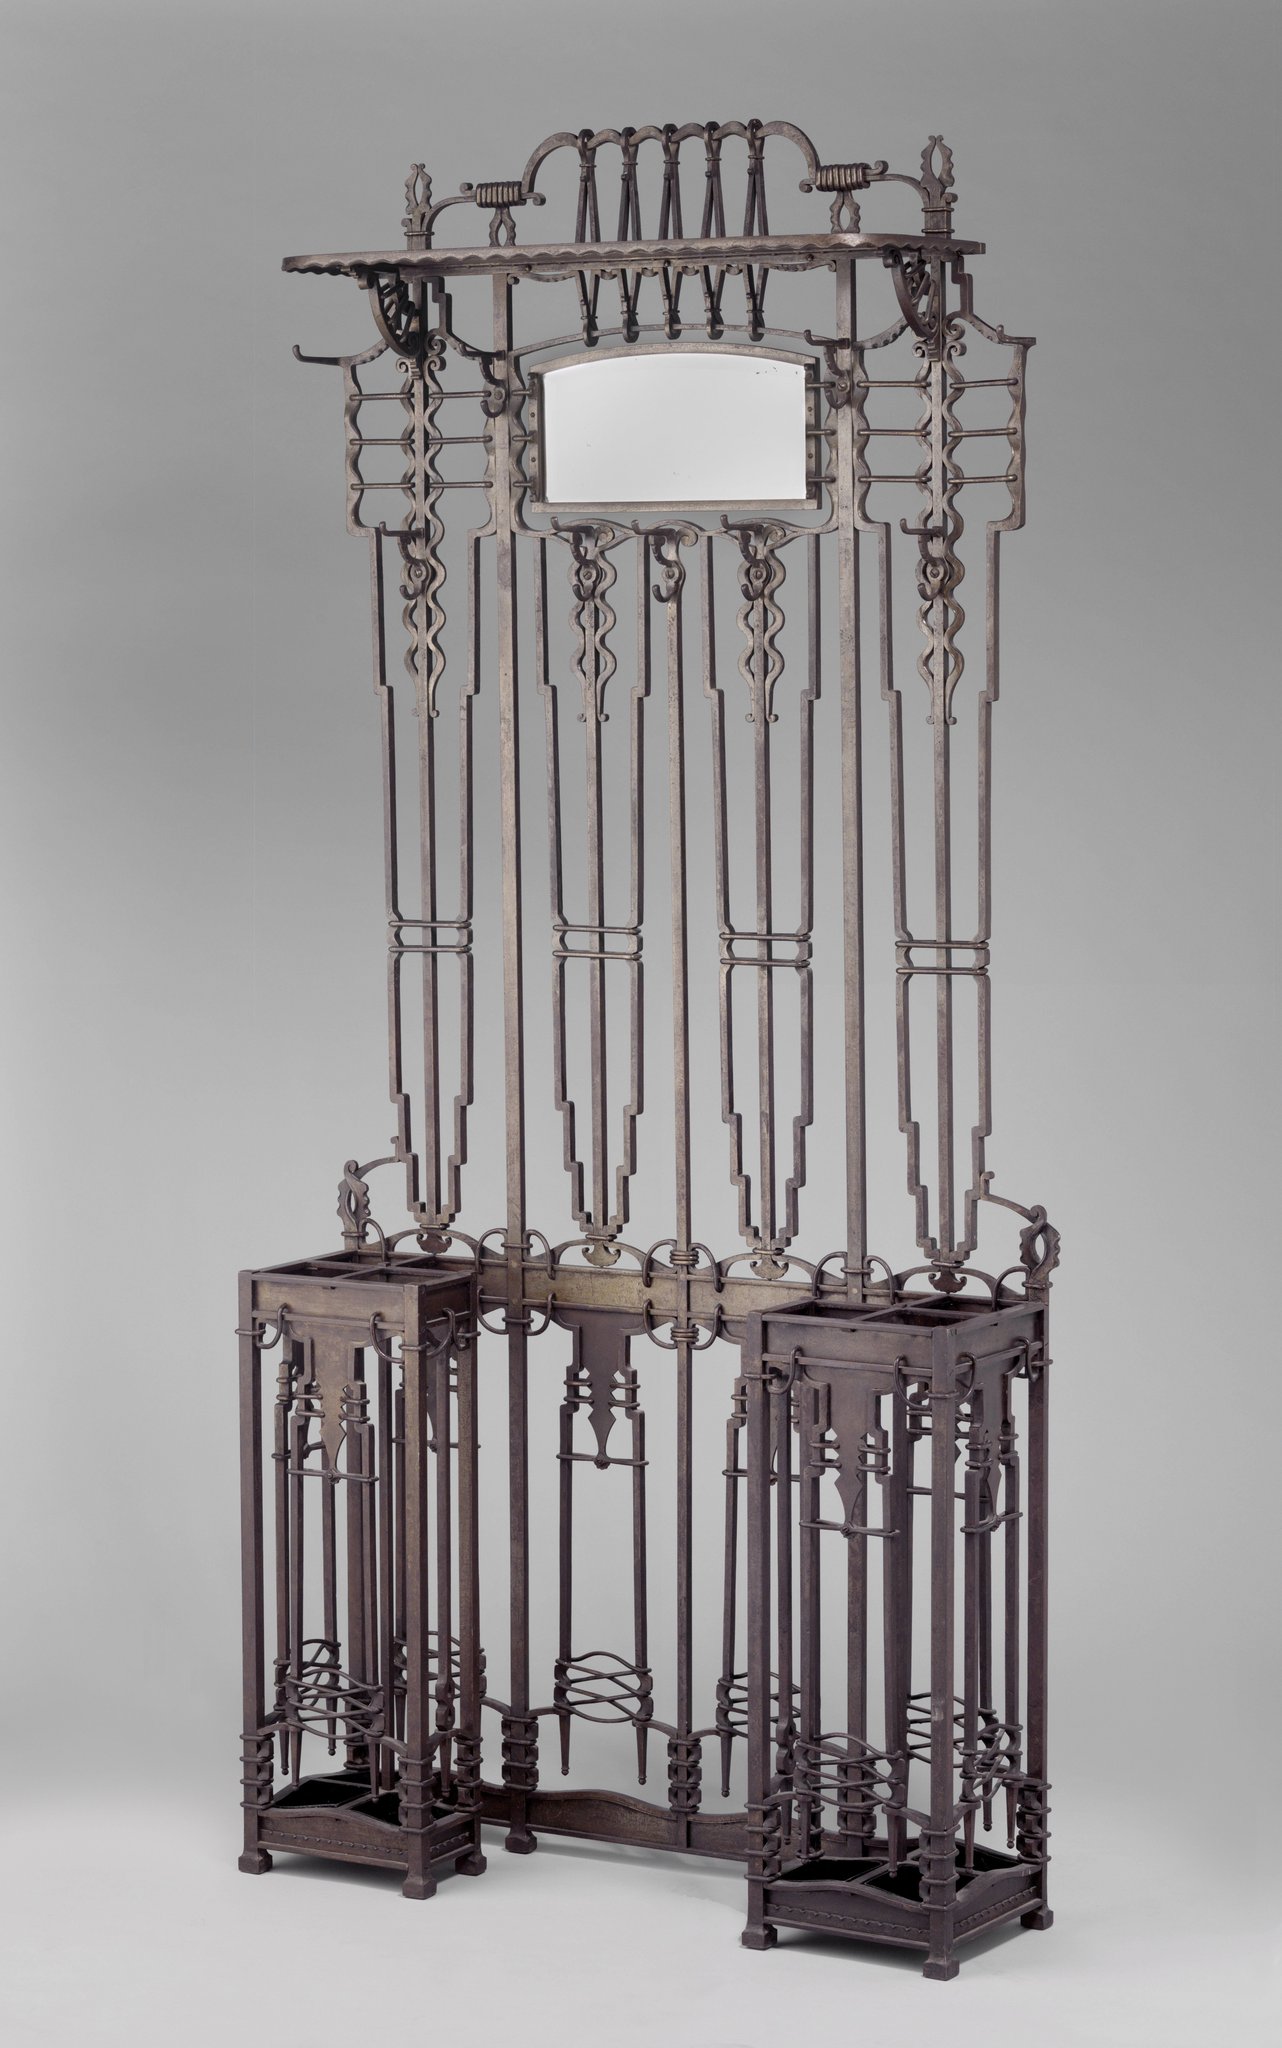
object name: furniture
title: Kapstok met hoedenplateau, spiegel en twee paraplubakken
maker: Anonymous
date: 1925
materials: glass, iron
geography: netherlands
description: Kapstok van smeedijzer, met hoedenplateau, spiegel en twee paraplubakken.